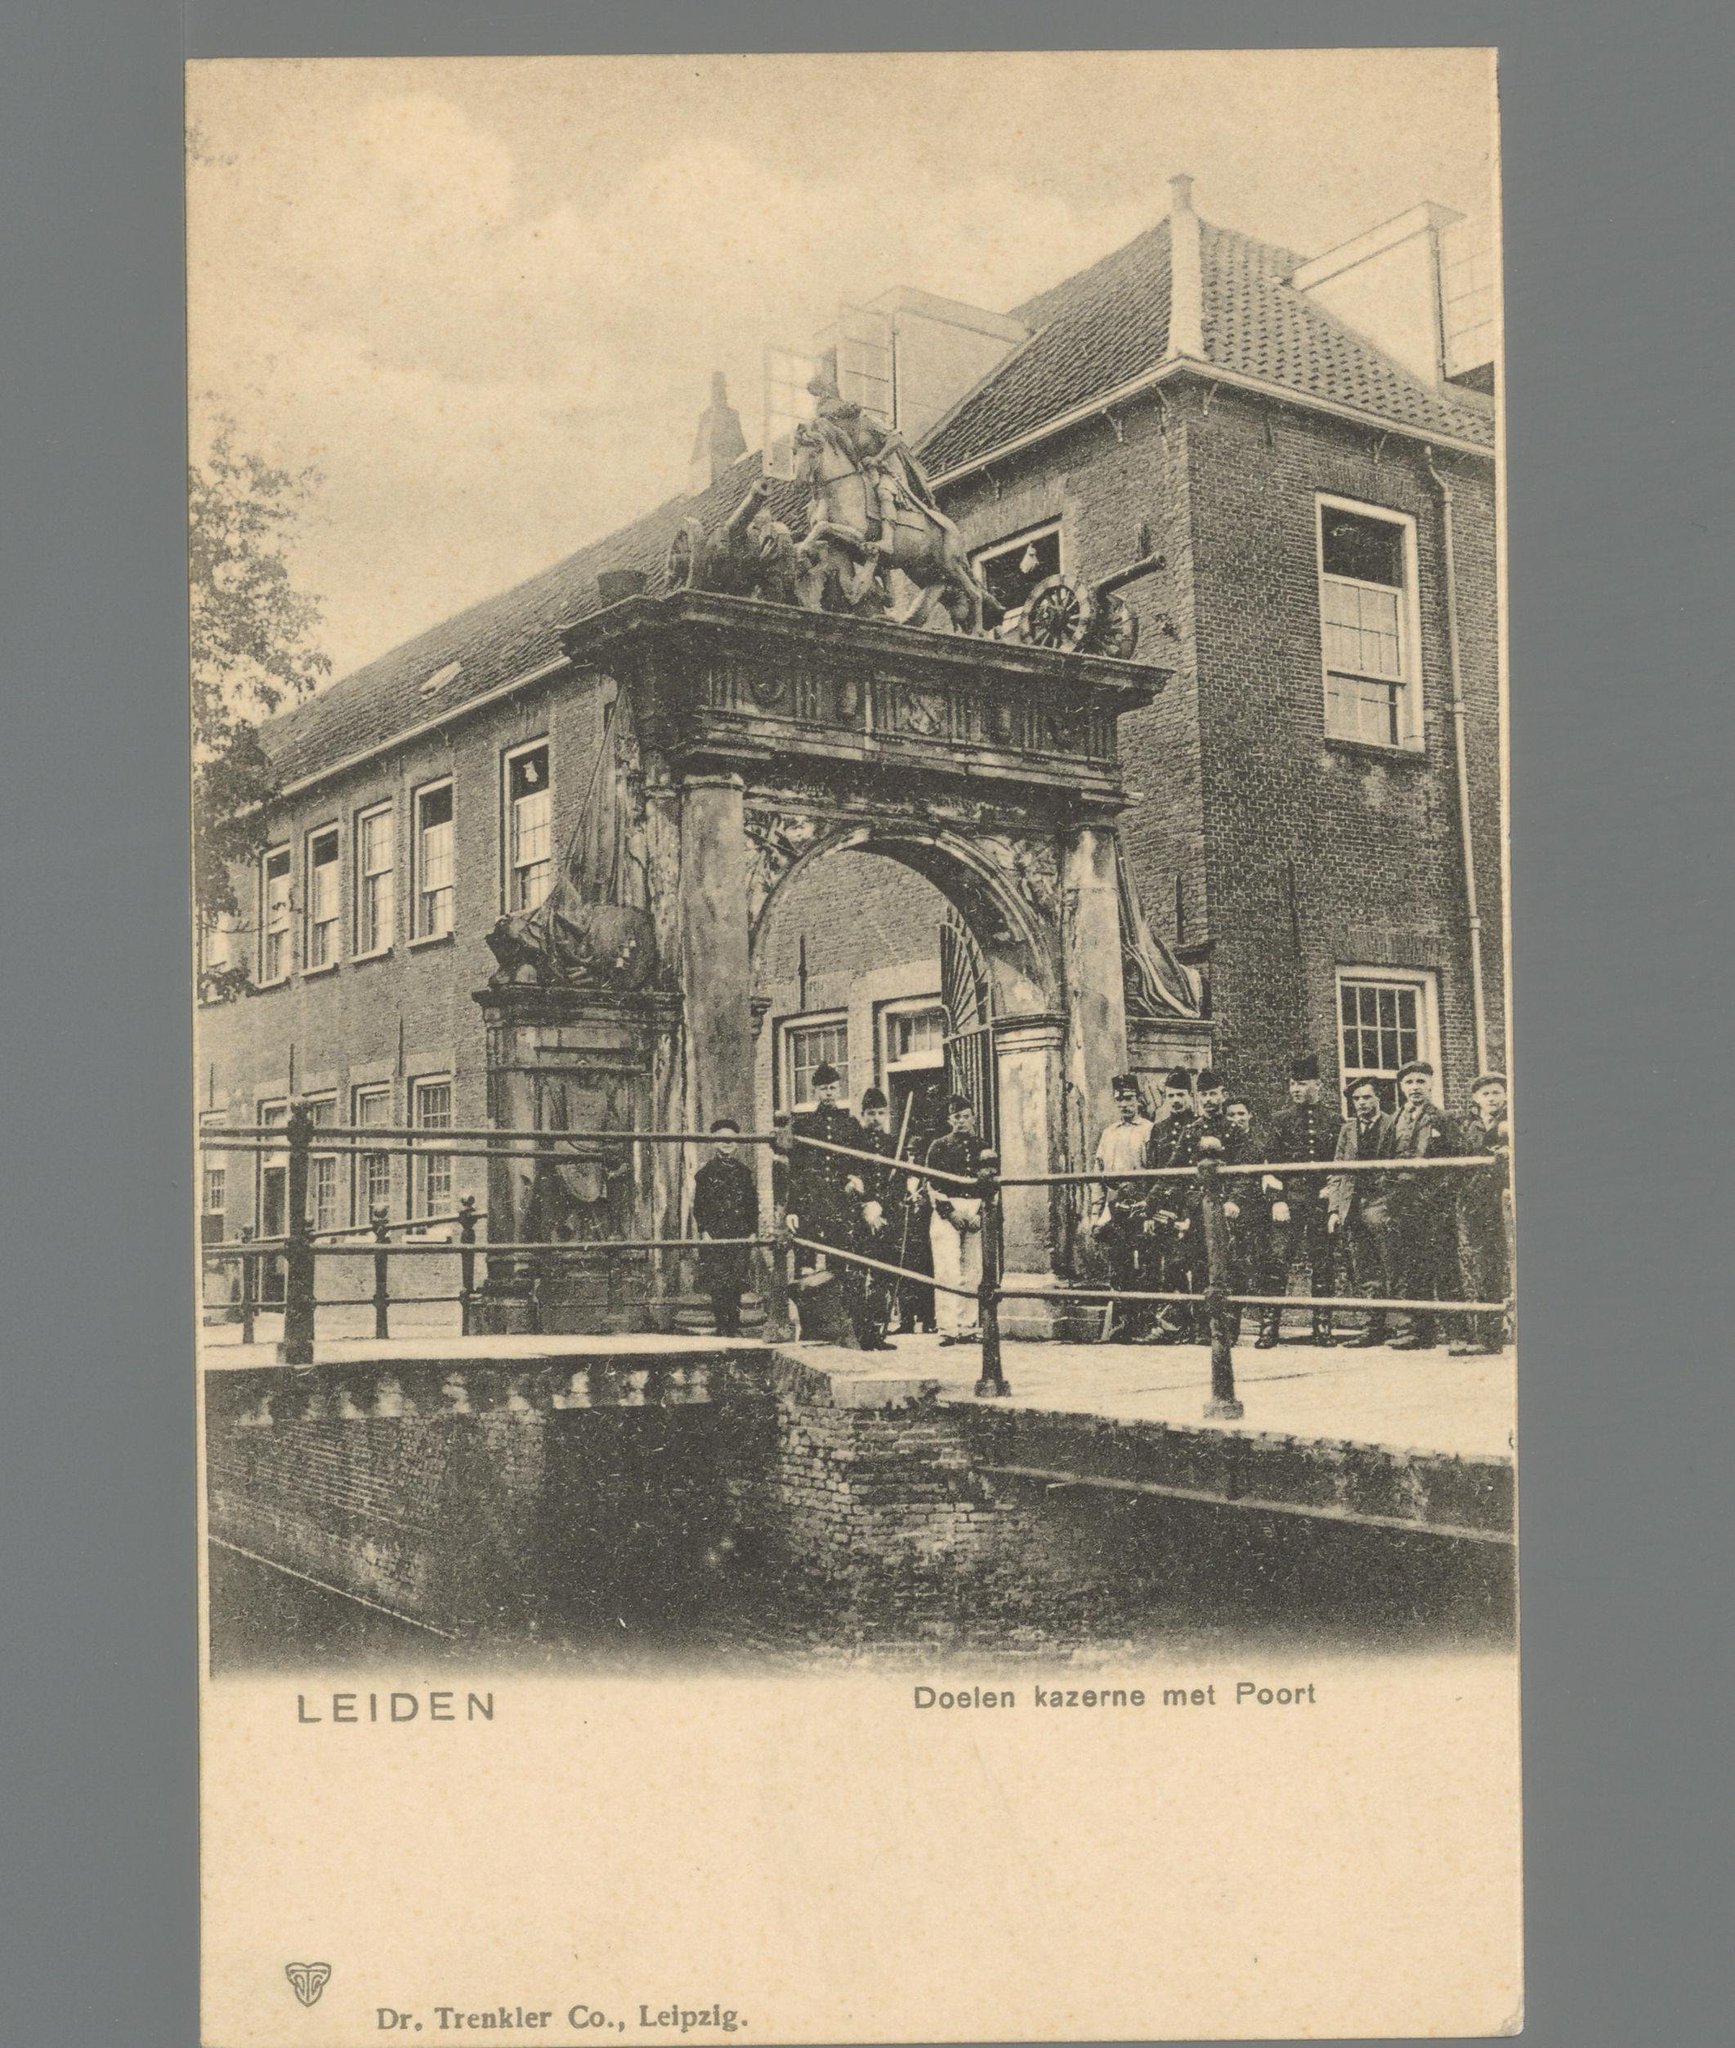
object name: photomechanical print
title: Leiden. Doelen kazerne met poort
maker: Anonymous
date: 1897-1905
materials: cardboard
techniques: photograph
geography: leipzig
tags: canal, city-gate, bridge in village across river, canal, etc.